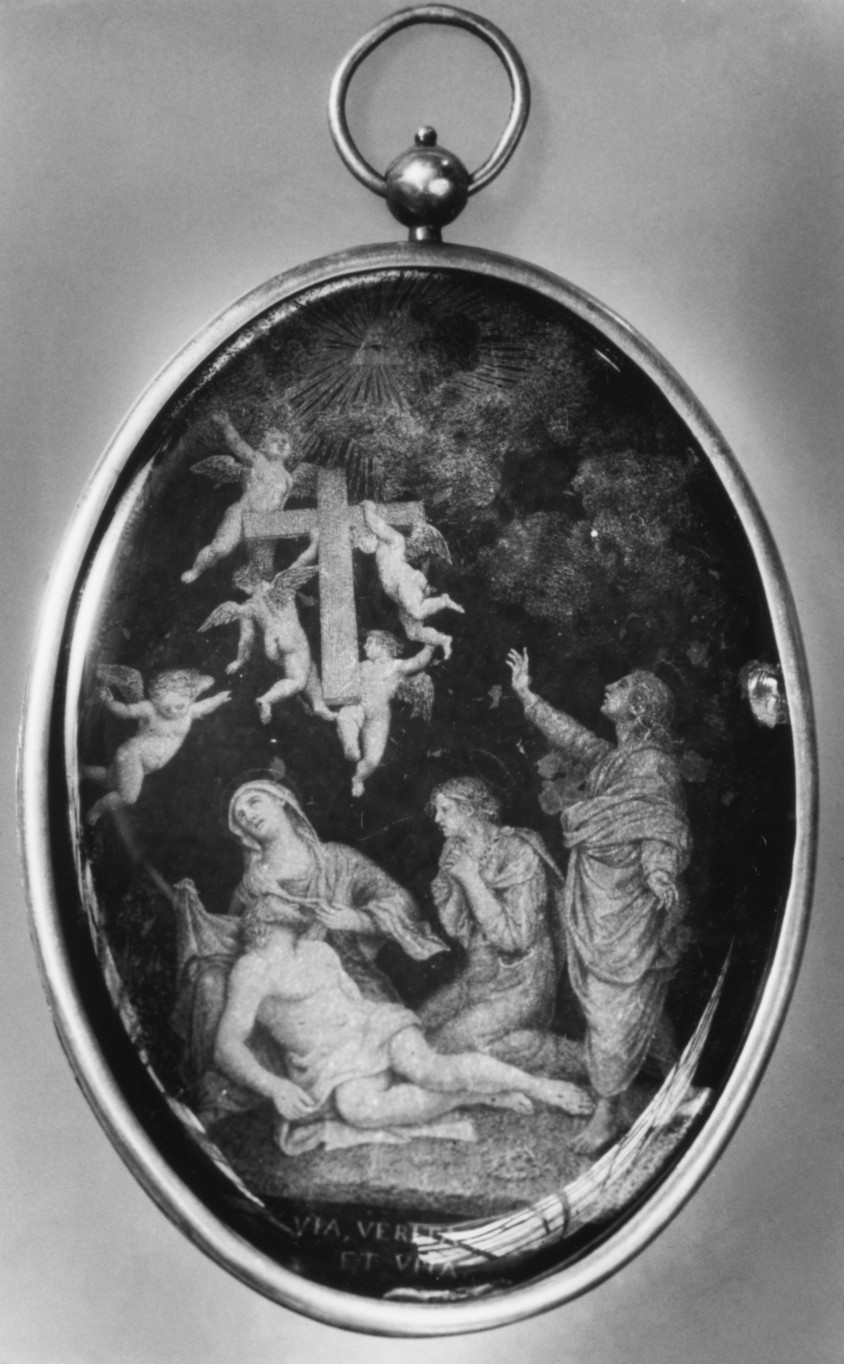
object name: pendant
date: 1767-1800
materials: glass, silver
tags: angels,christ,virgin mary,cross